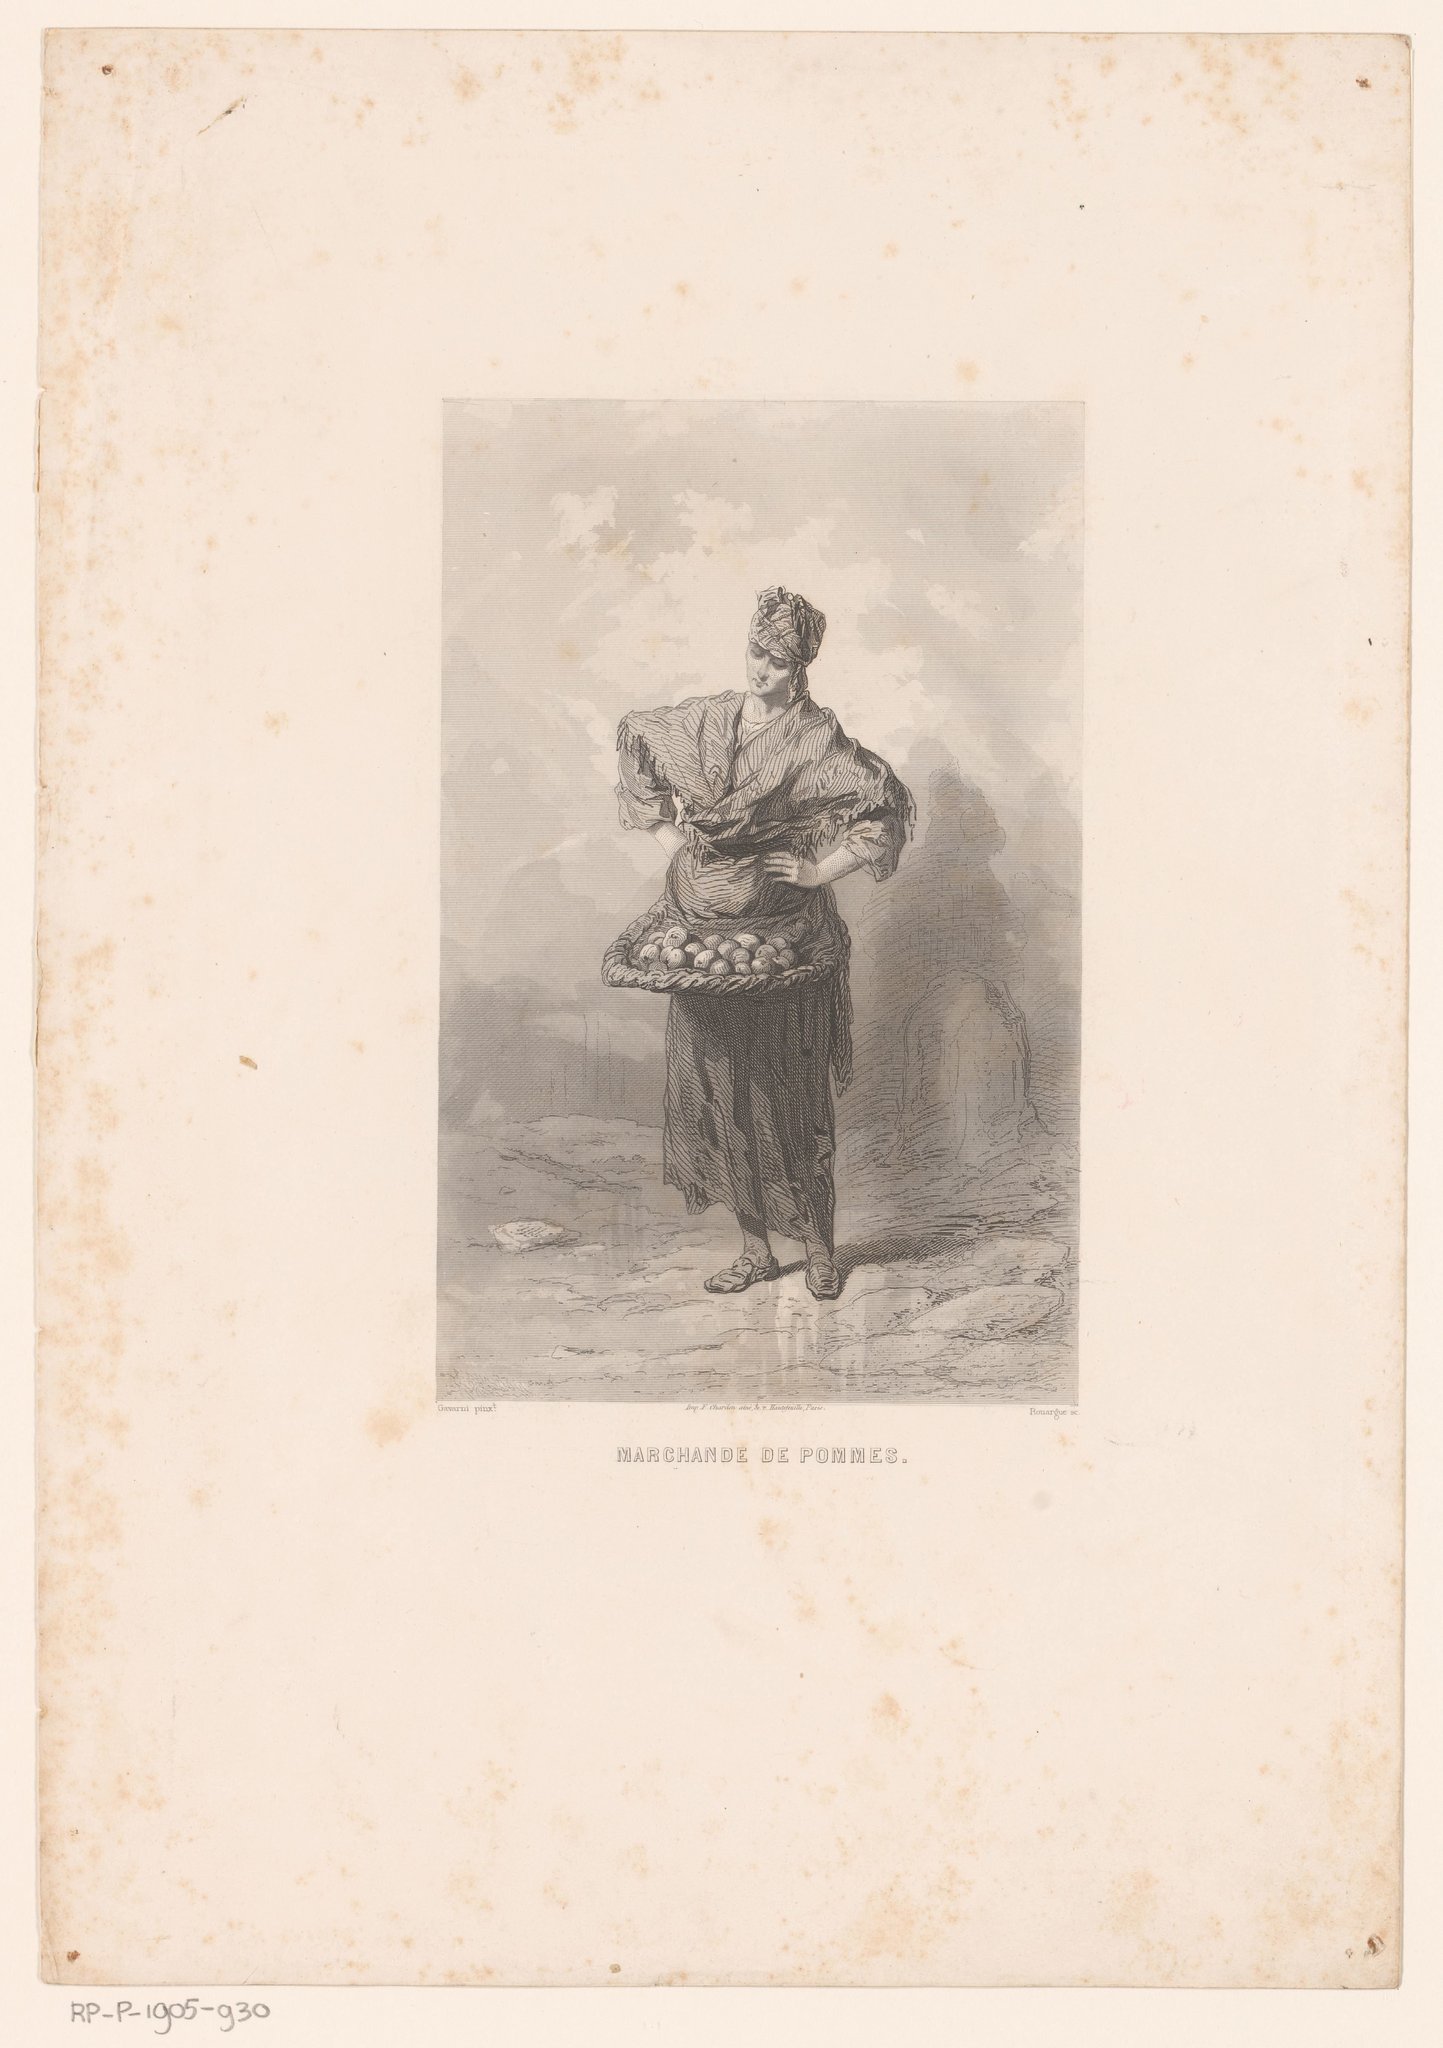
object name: book illustration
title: Marchande de Pommes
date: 1856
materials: paper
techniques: engraving, etching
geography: paris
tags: fruits: apple, merchant, salesman - bb - women engaged in trade and commerce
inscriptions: collector's mark: Lugt 2228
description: Prent uit: Dumas, Alexandre et al. Paris et les Parisiens au XIXe siècle. Parijs: Morizot, 1856.